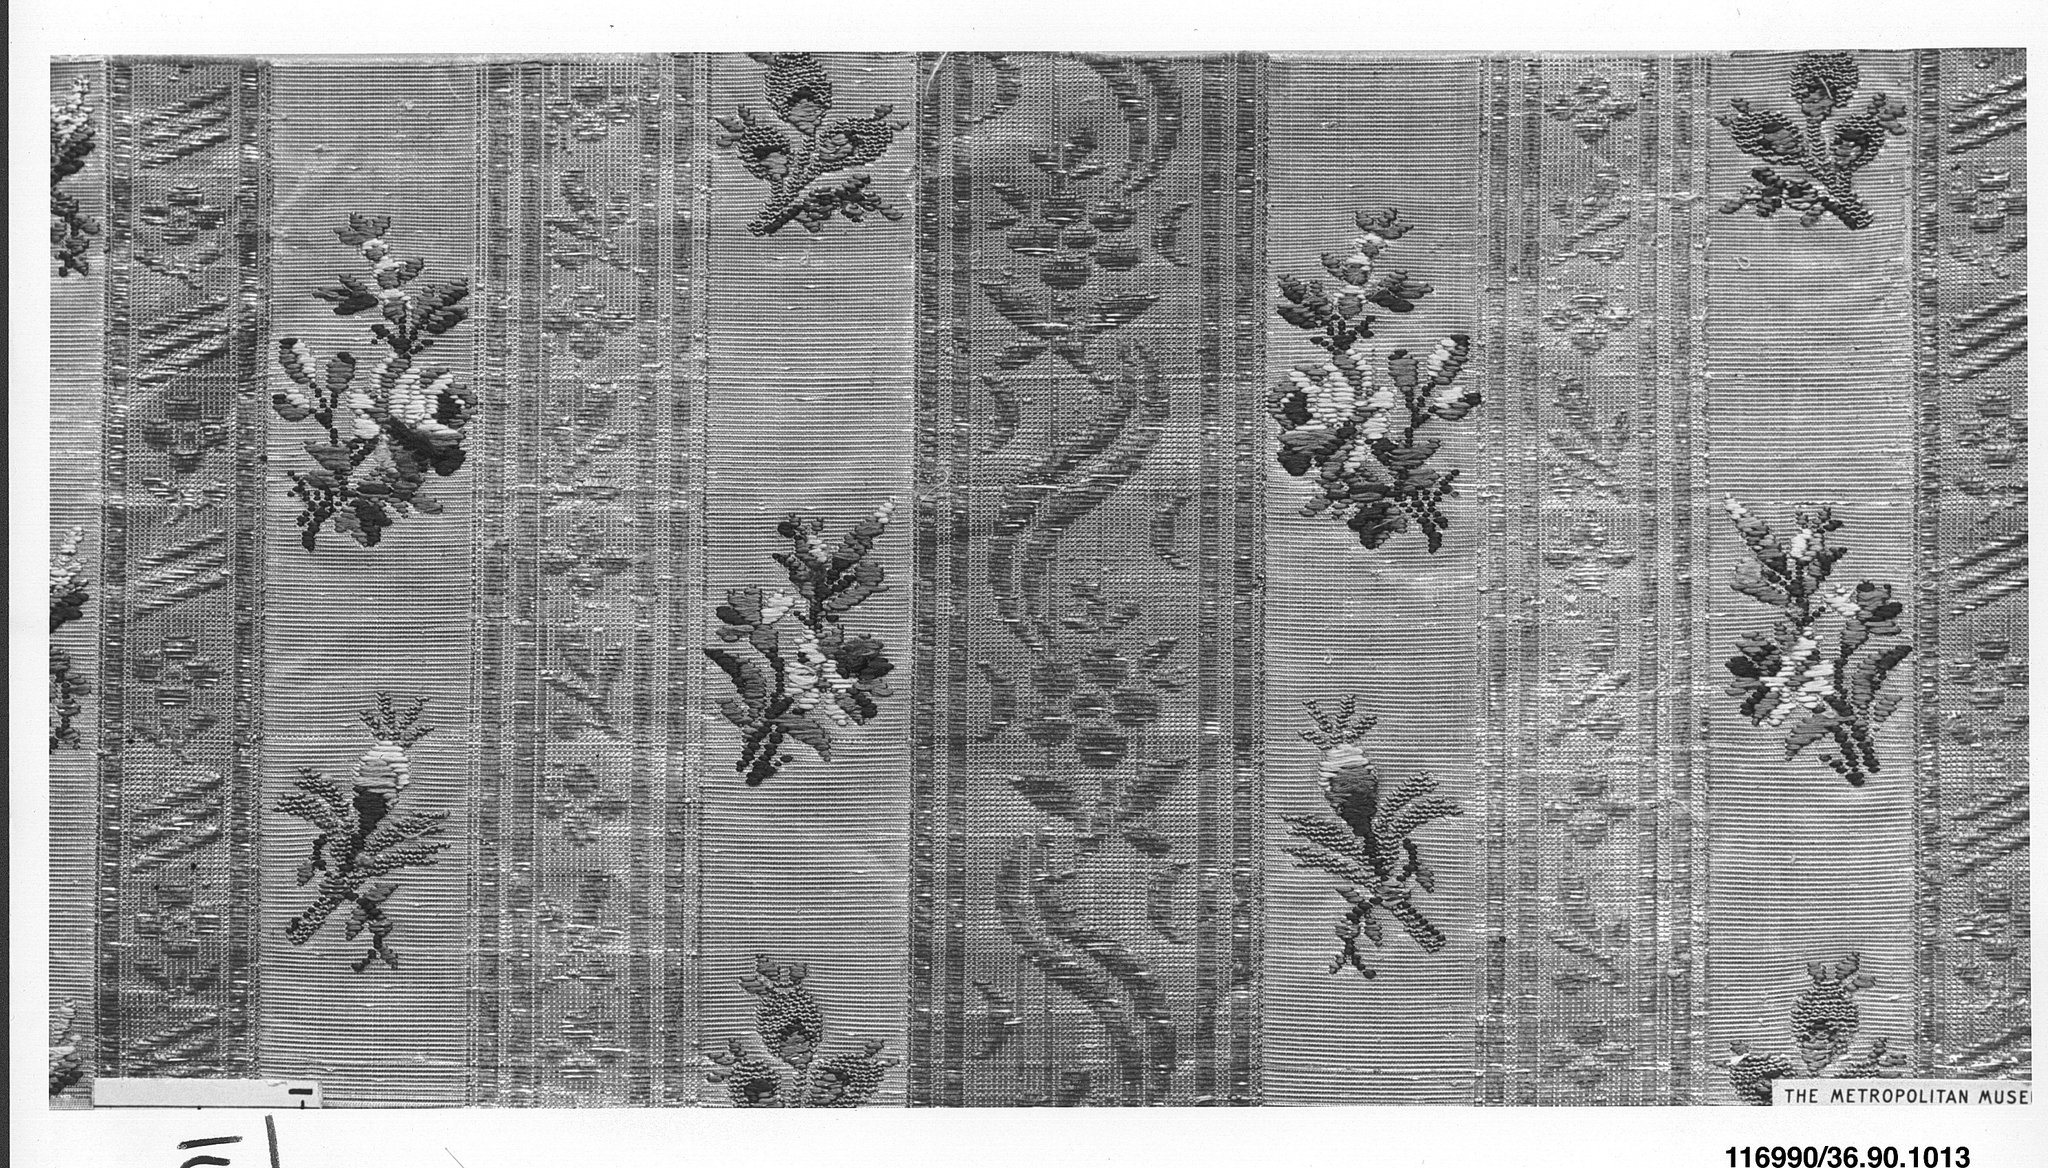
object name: piece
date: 1701-1800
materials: metal thread, silk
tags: flowers,leaves